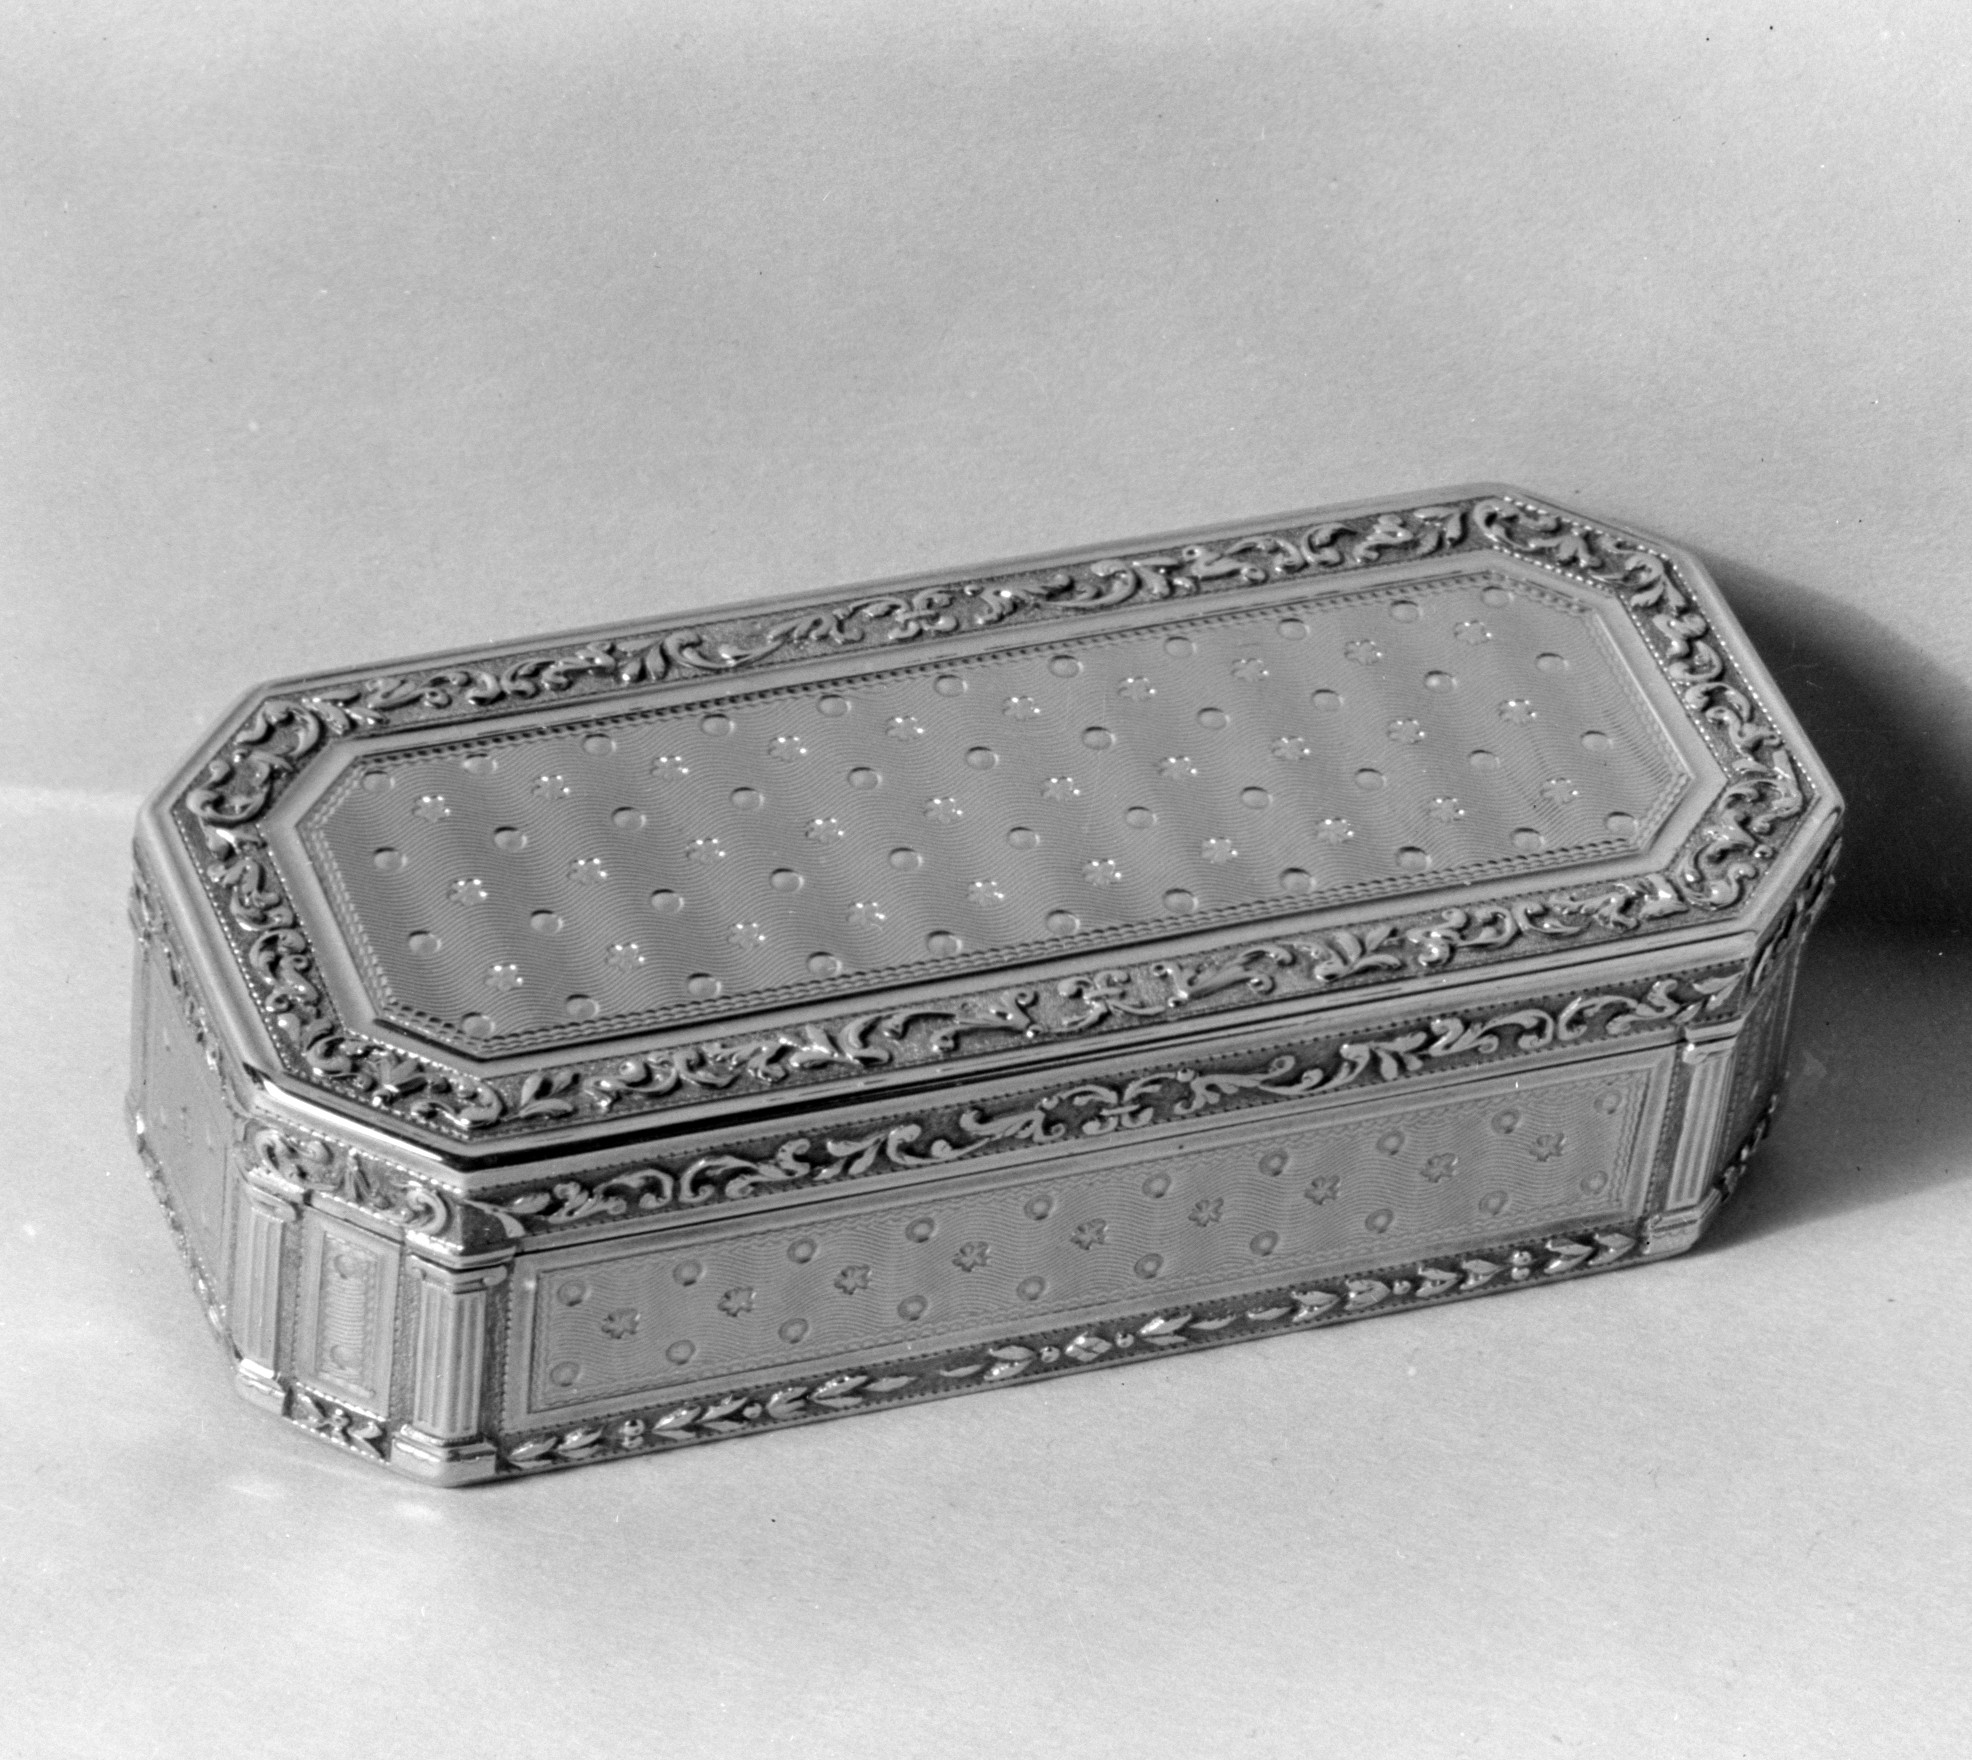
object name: box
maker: jacques françois varin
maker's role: maker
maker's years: 1728-1828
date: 1788-1789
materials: gold